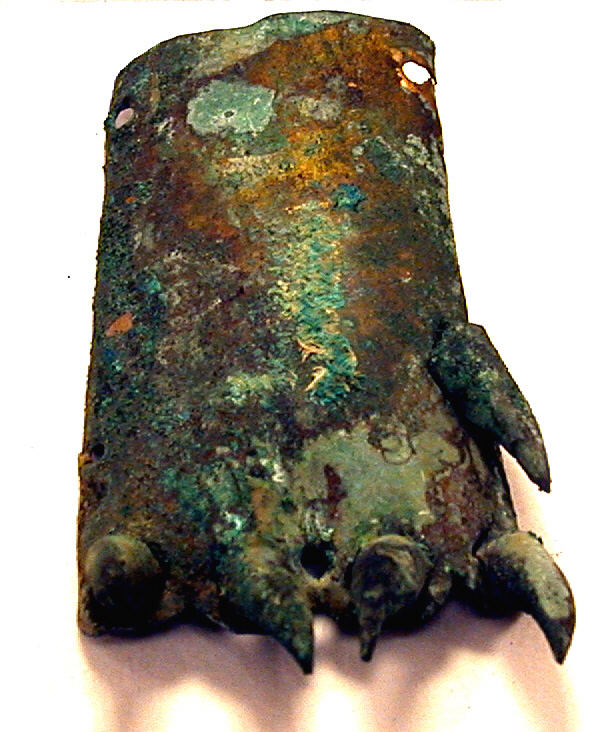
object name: ornament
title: Animal Ornament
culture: moche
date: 501-700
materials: gilt copper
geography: peru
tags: animals